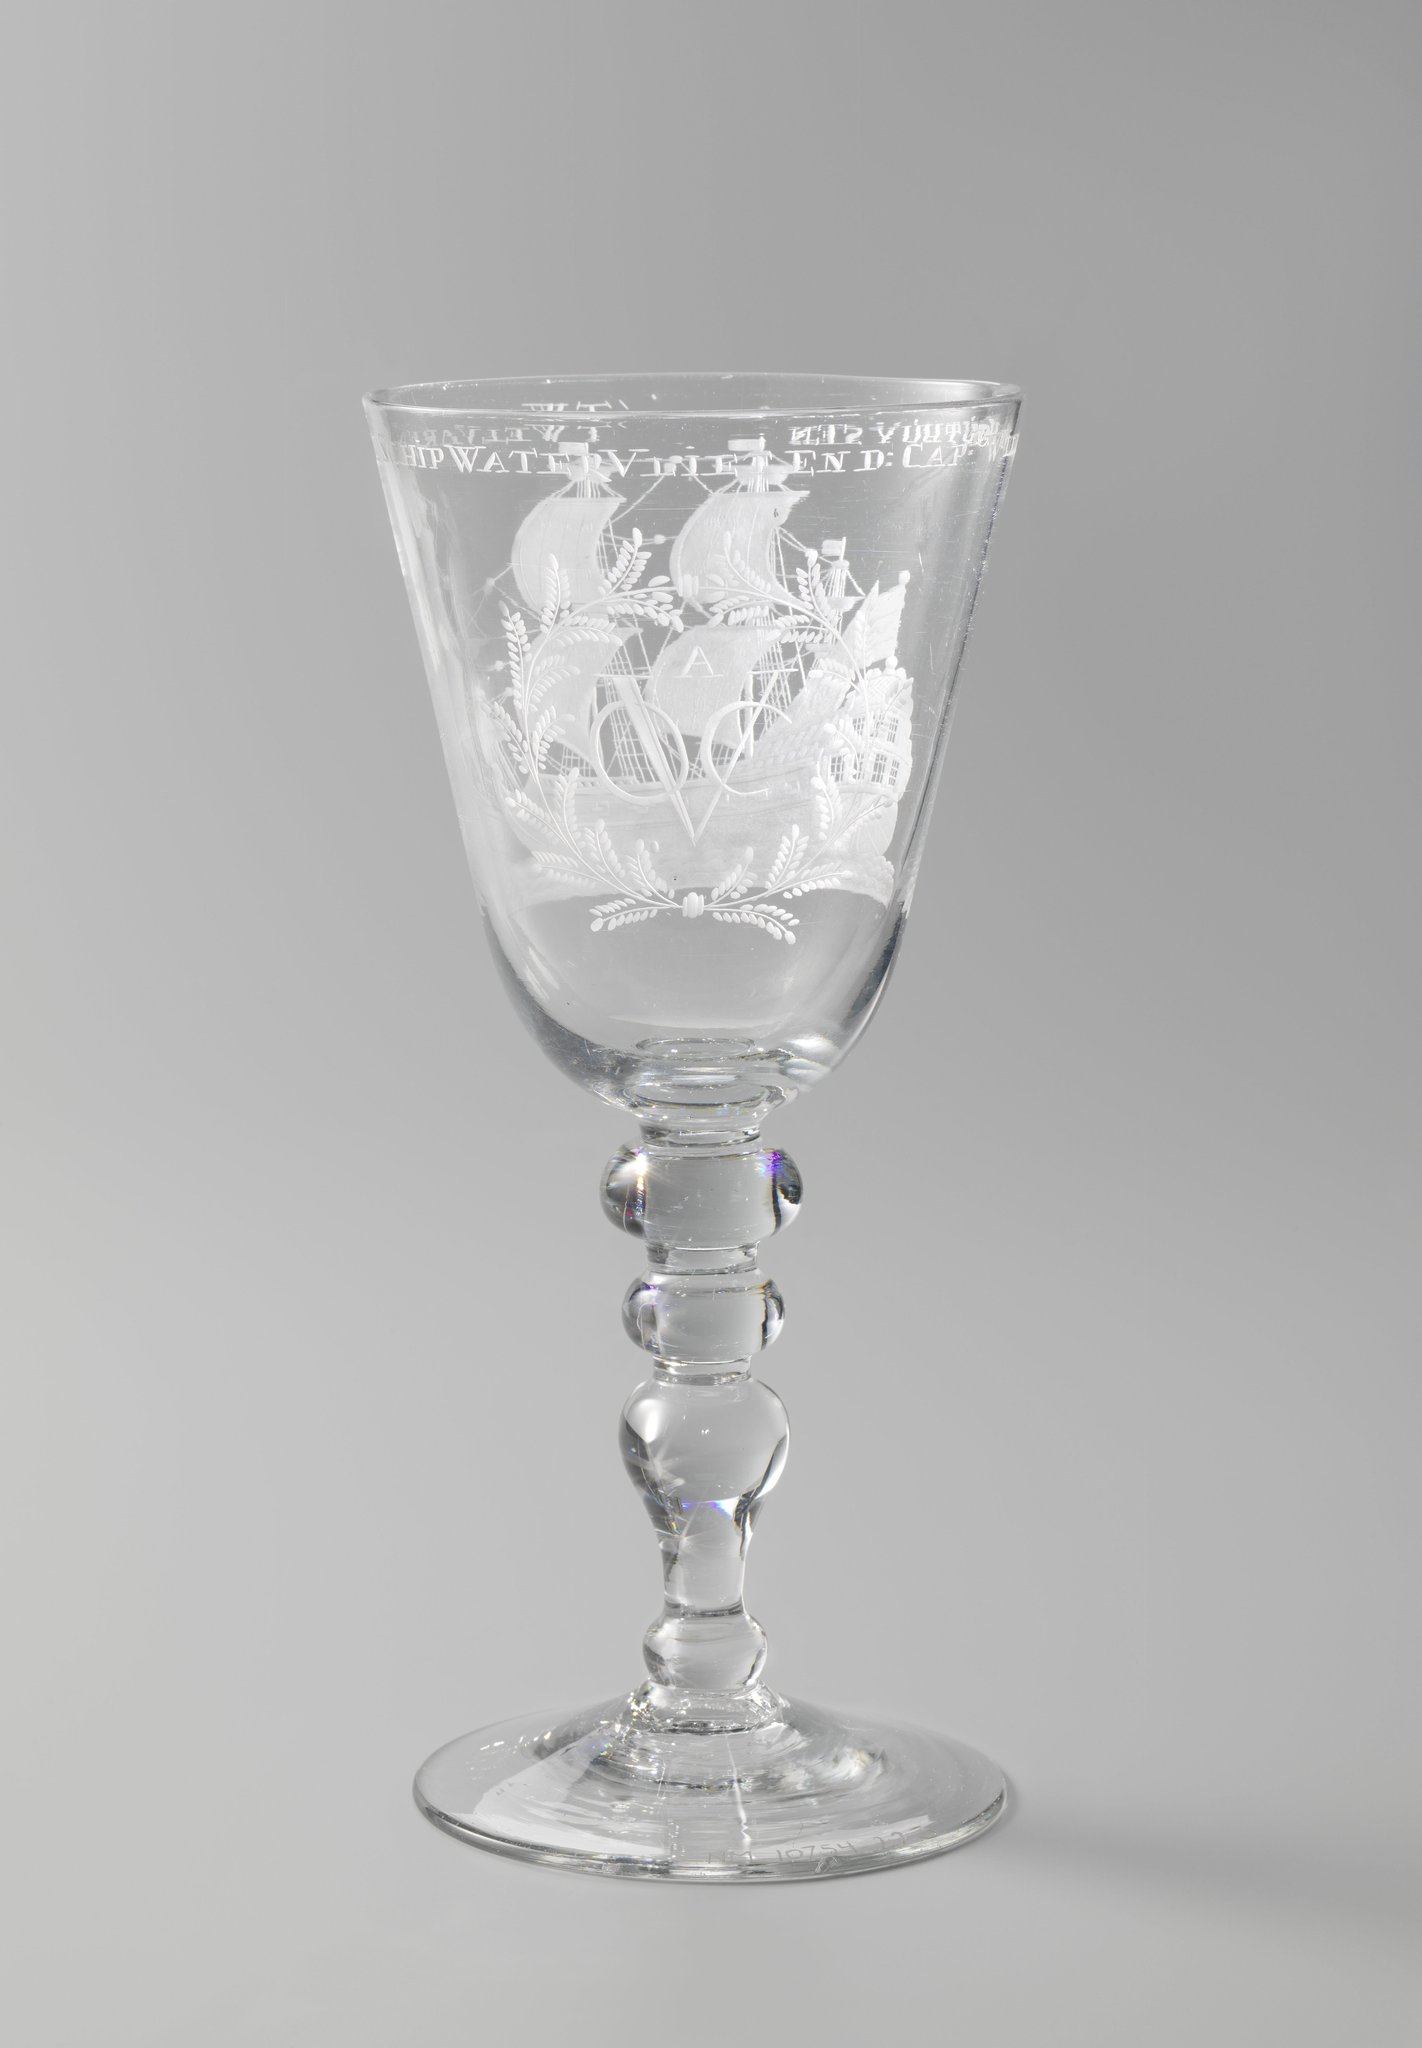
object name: goblet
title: Wine glass with a ship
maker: Anonymous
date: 1725-1750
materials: glass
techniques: glassblowing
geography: northern netherlands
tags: sailing-ship, sailing-boat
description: translation of inscription: The Prosperity of the Ship < Watervliet > and the Capt. Willem Houthuysen